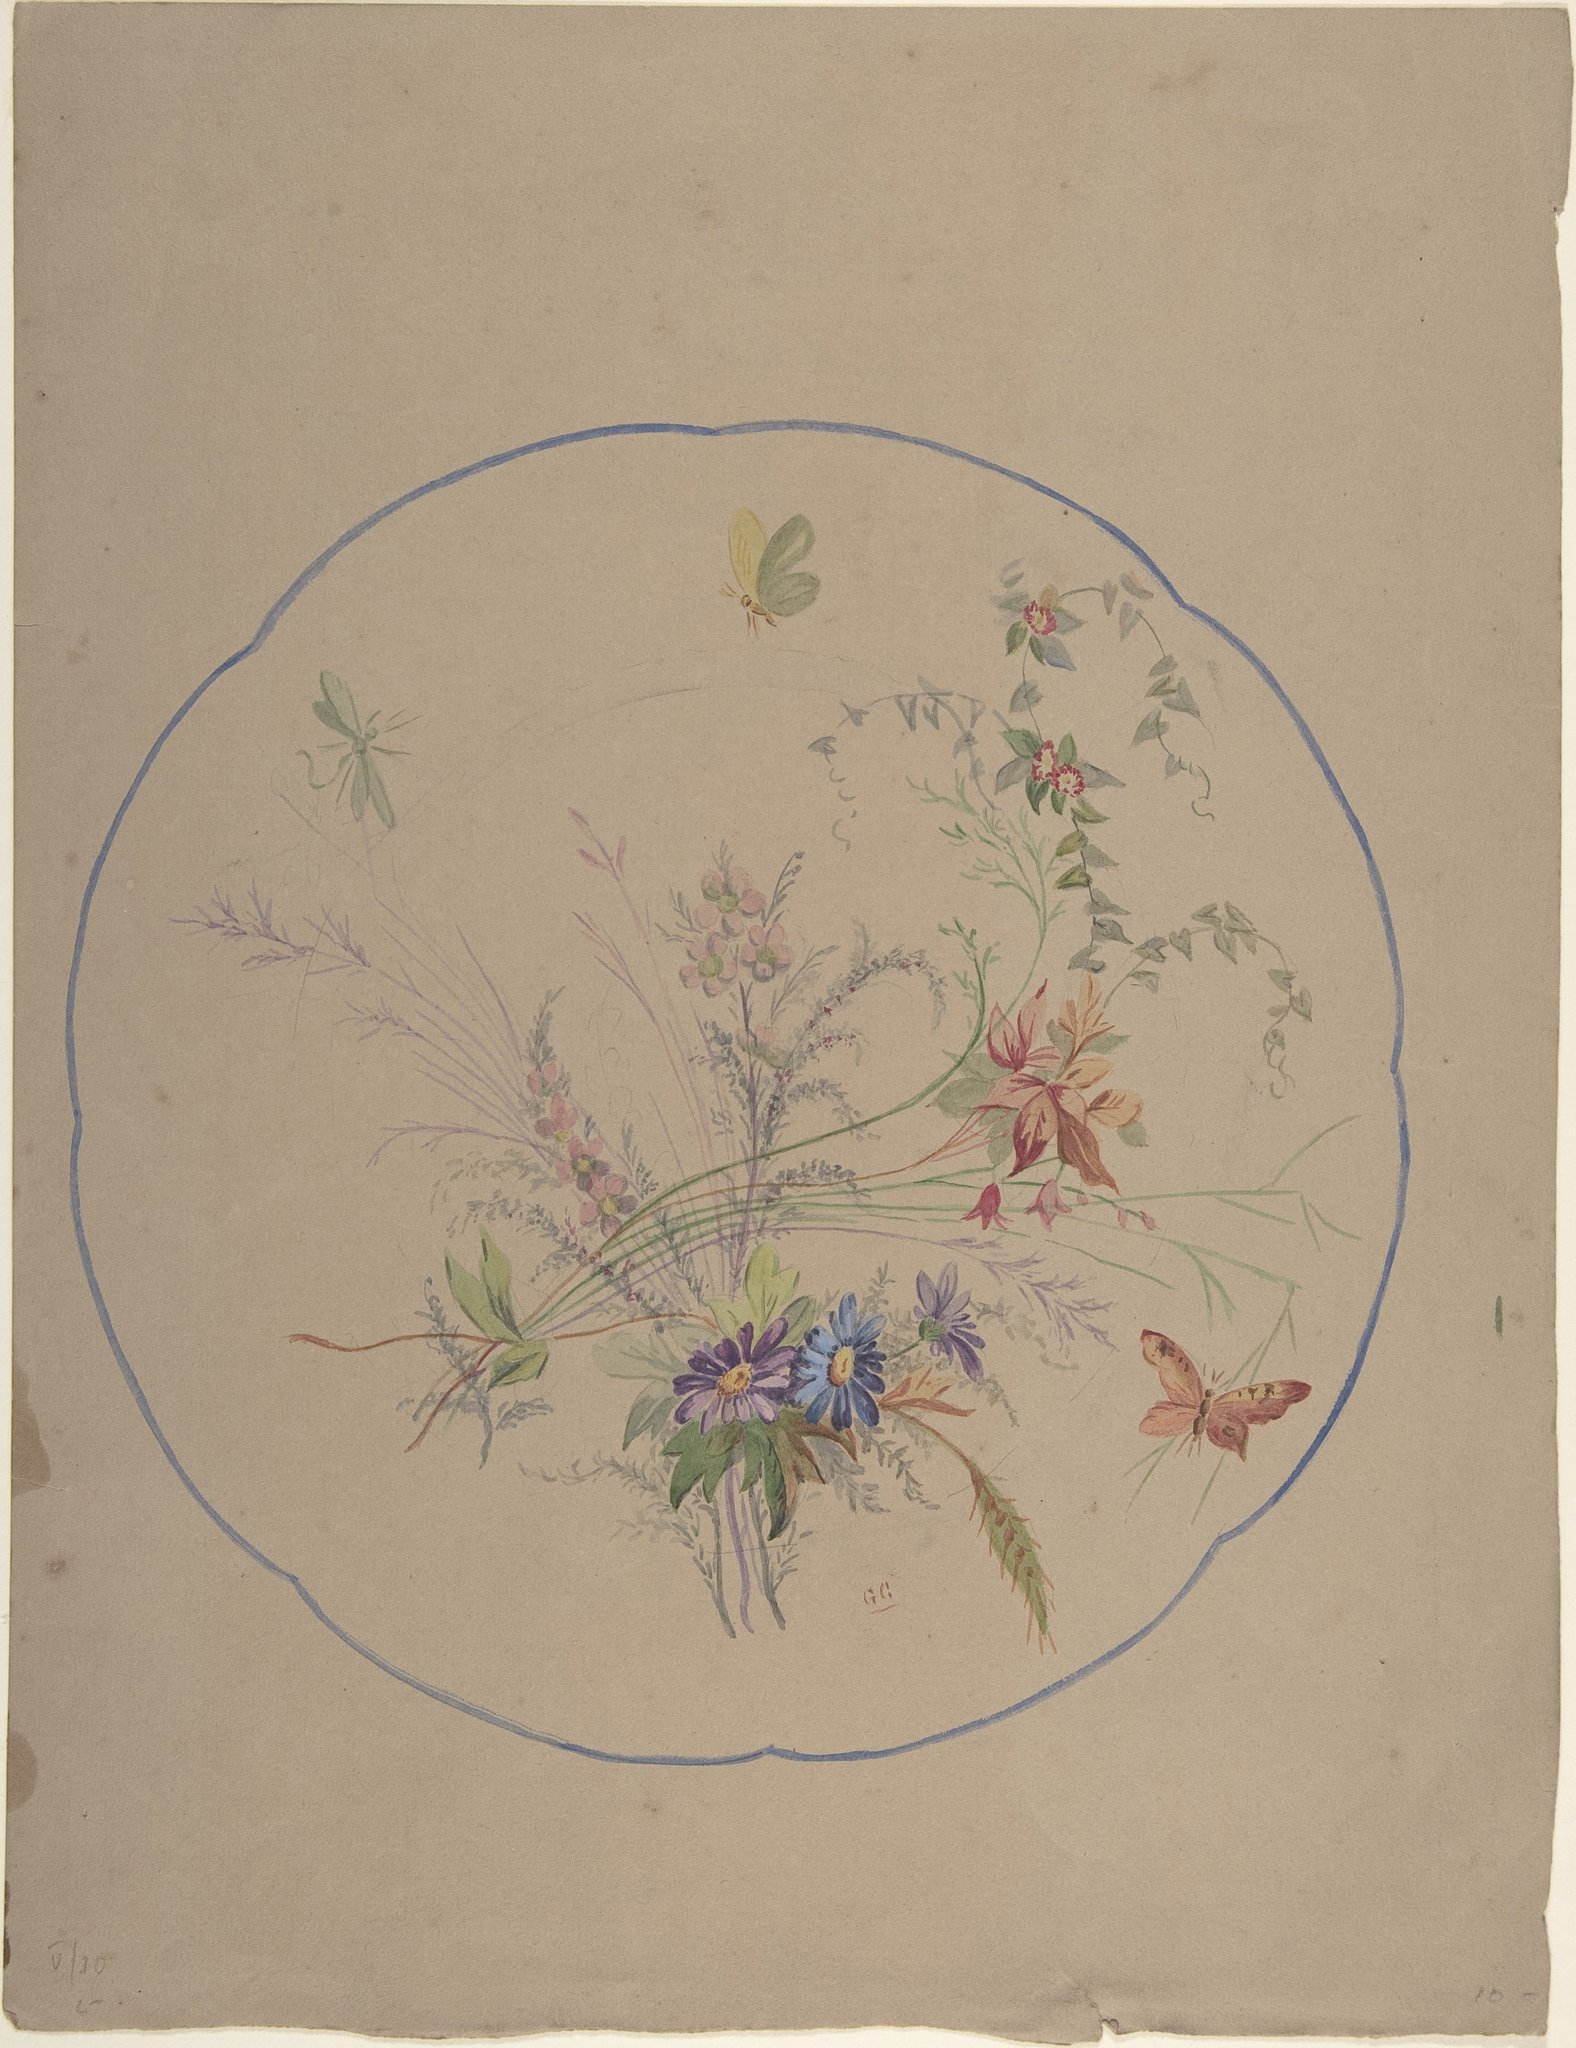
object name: drawing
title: Design of Flower Sprays and Butterflies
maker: anonymous, italian, 19th century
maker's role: artist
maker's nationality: italian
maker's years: 1800-1900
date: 1870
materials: watercolor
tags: butterflies,flowers